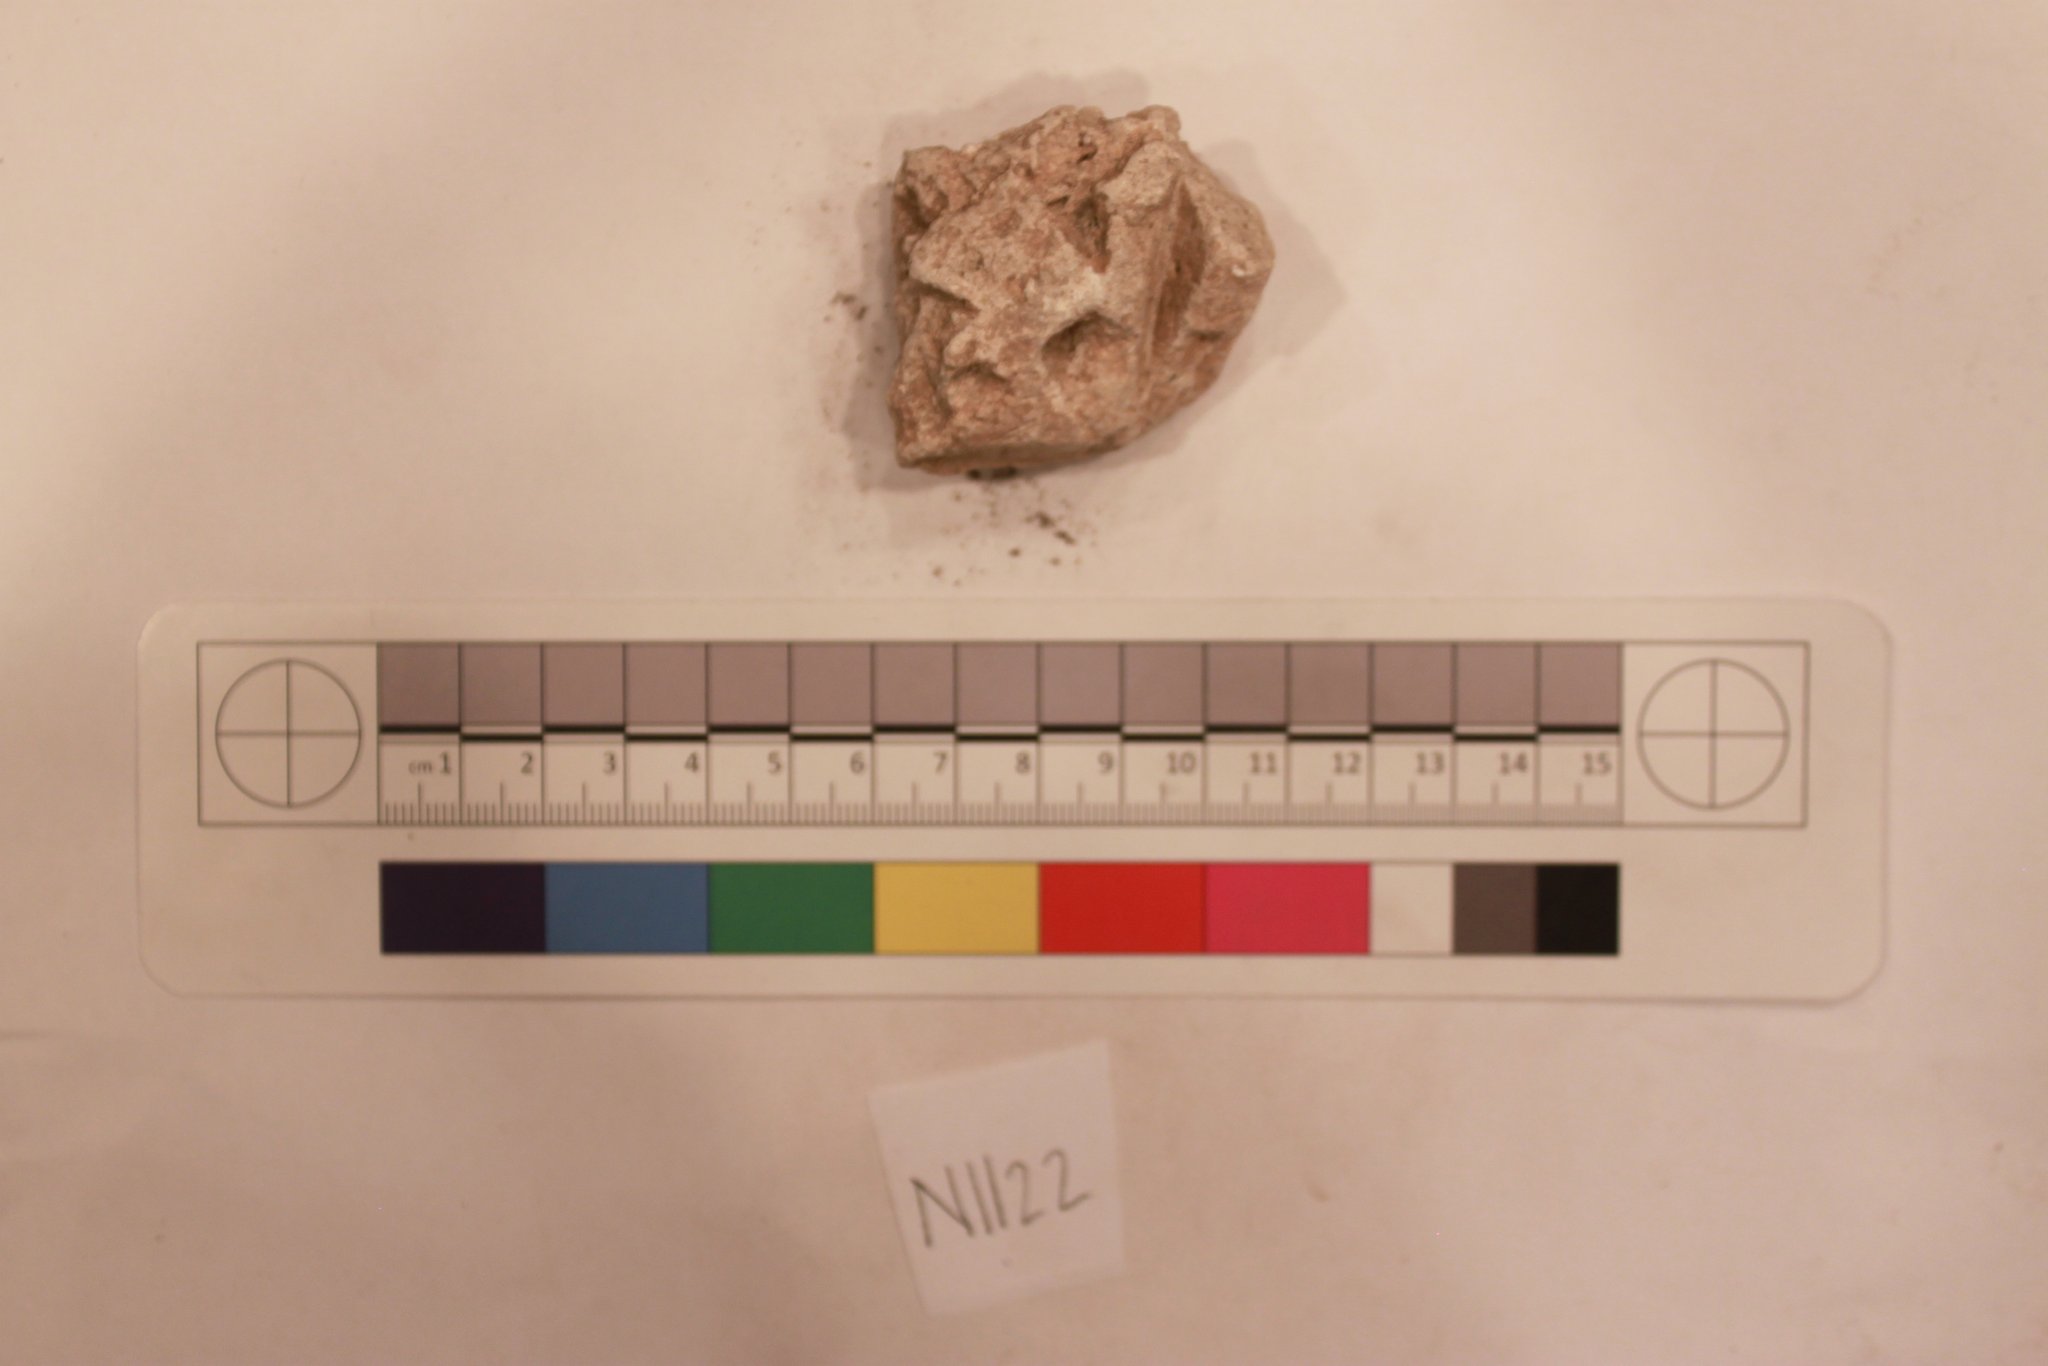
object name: fragment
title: Stucco Fragment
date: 701-1200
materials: plaster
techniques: carving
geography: iran